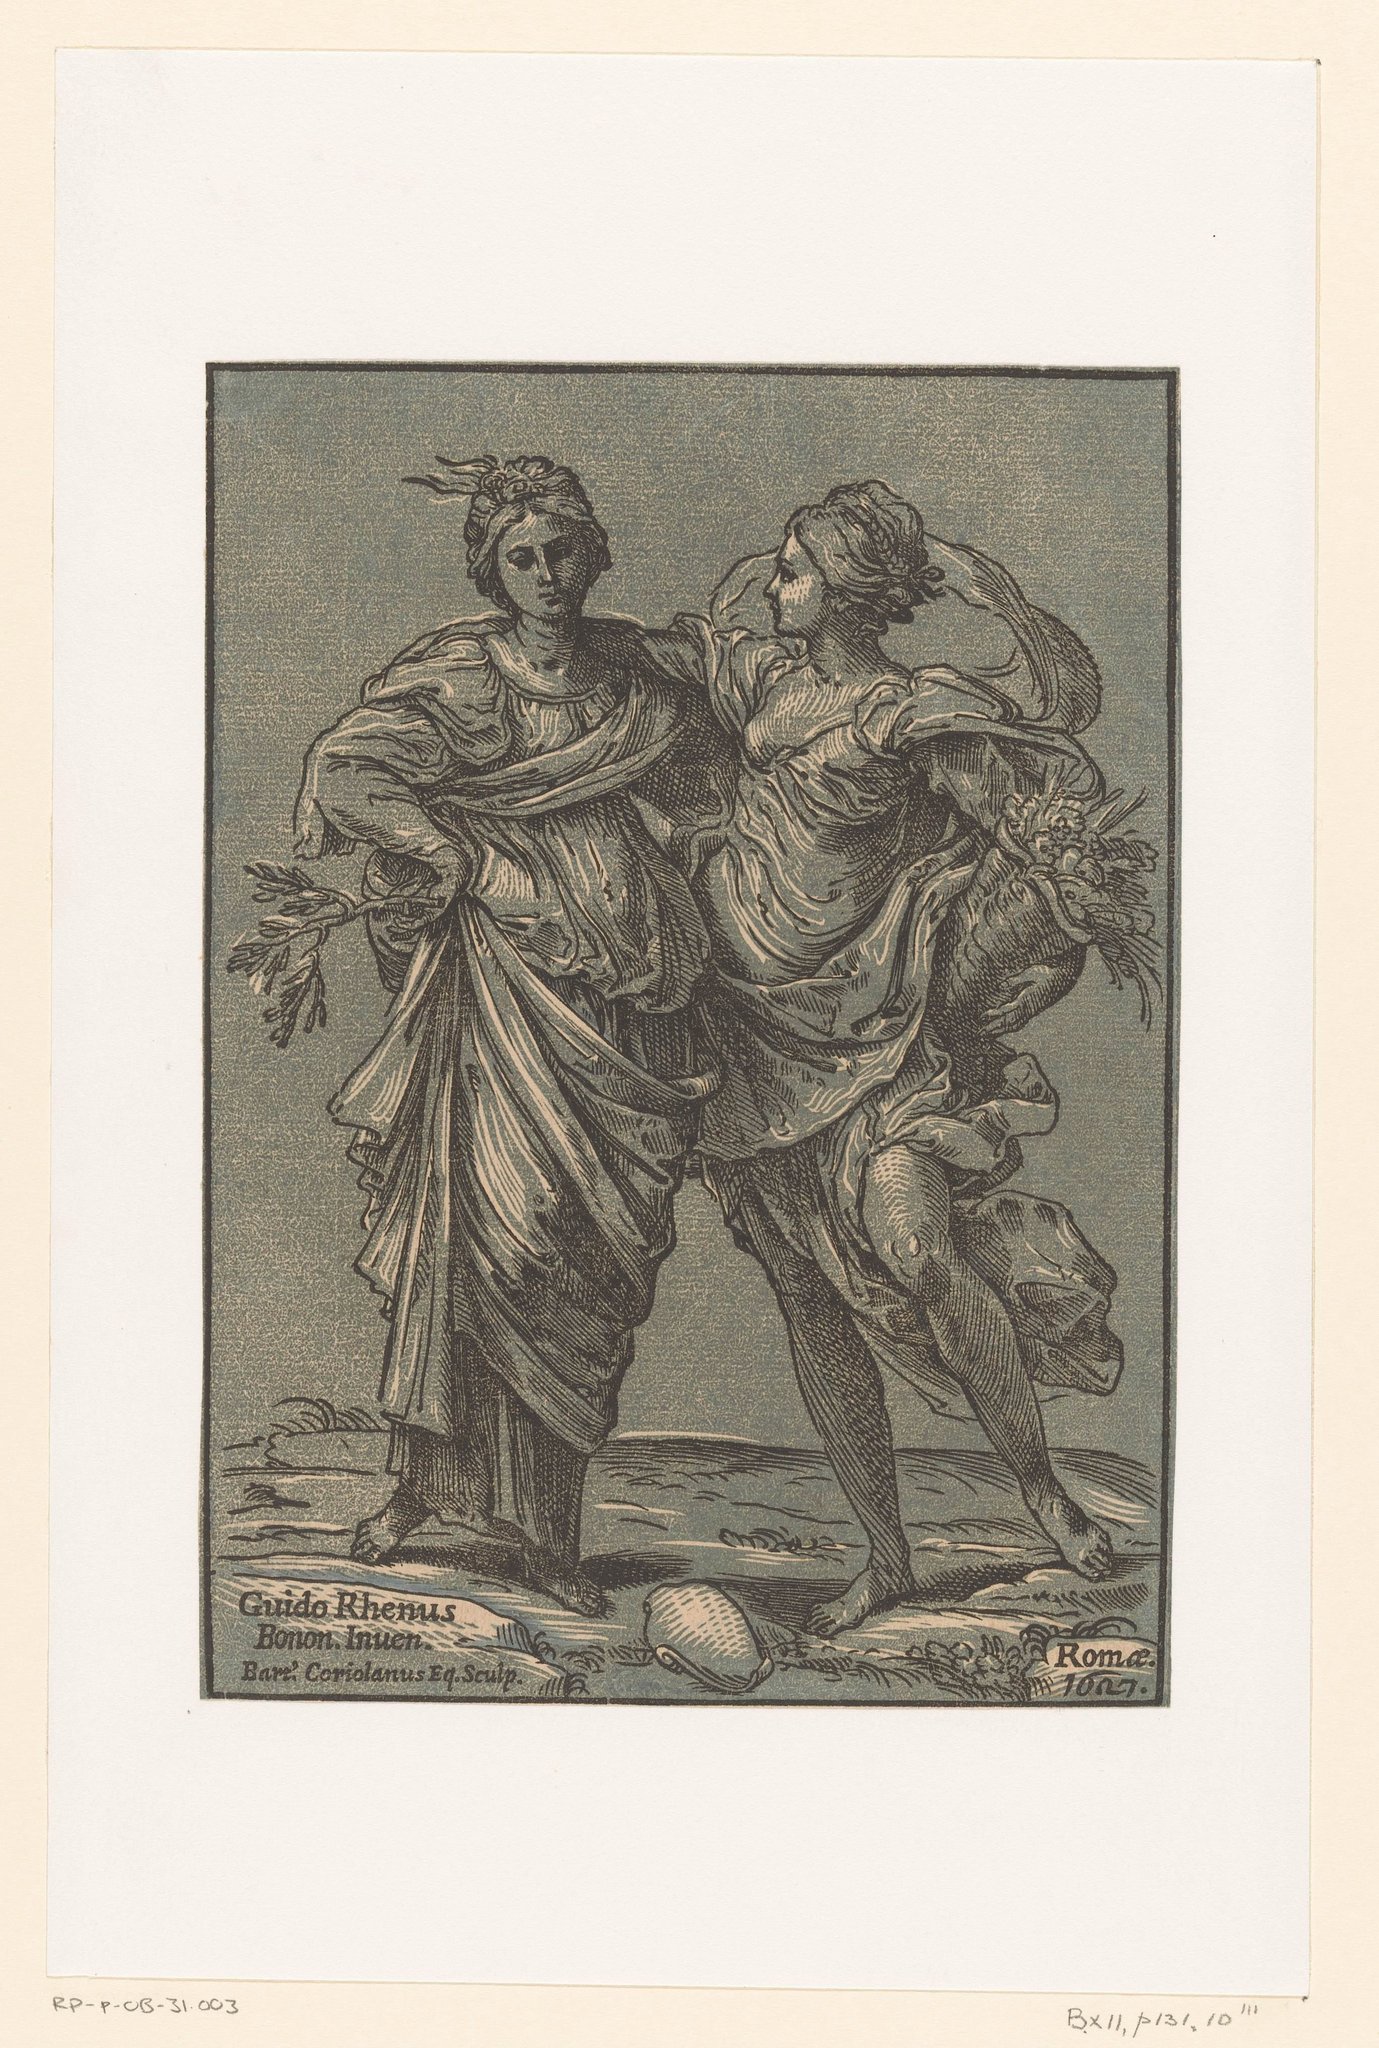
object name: print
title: Vrede en Overvloed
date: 1627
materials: paper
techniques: woodcut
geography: rome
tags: peace and prosperity, 'pax et abundantia'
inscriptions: collector's mark: Lugt 240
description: Vrouwelijke personificaties van de vrede (Pax) met olijftak en van de overvloed (Abundantia) met hoorn des overvloeds (cornucopia).